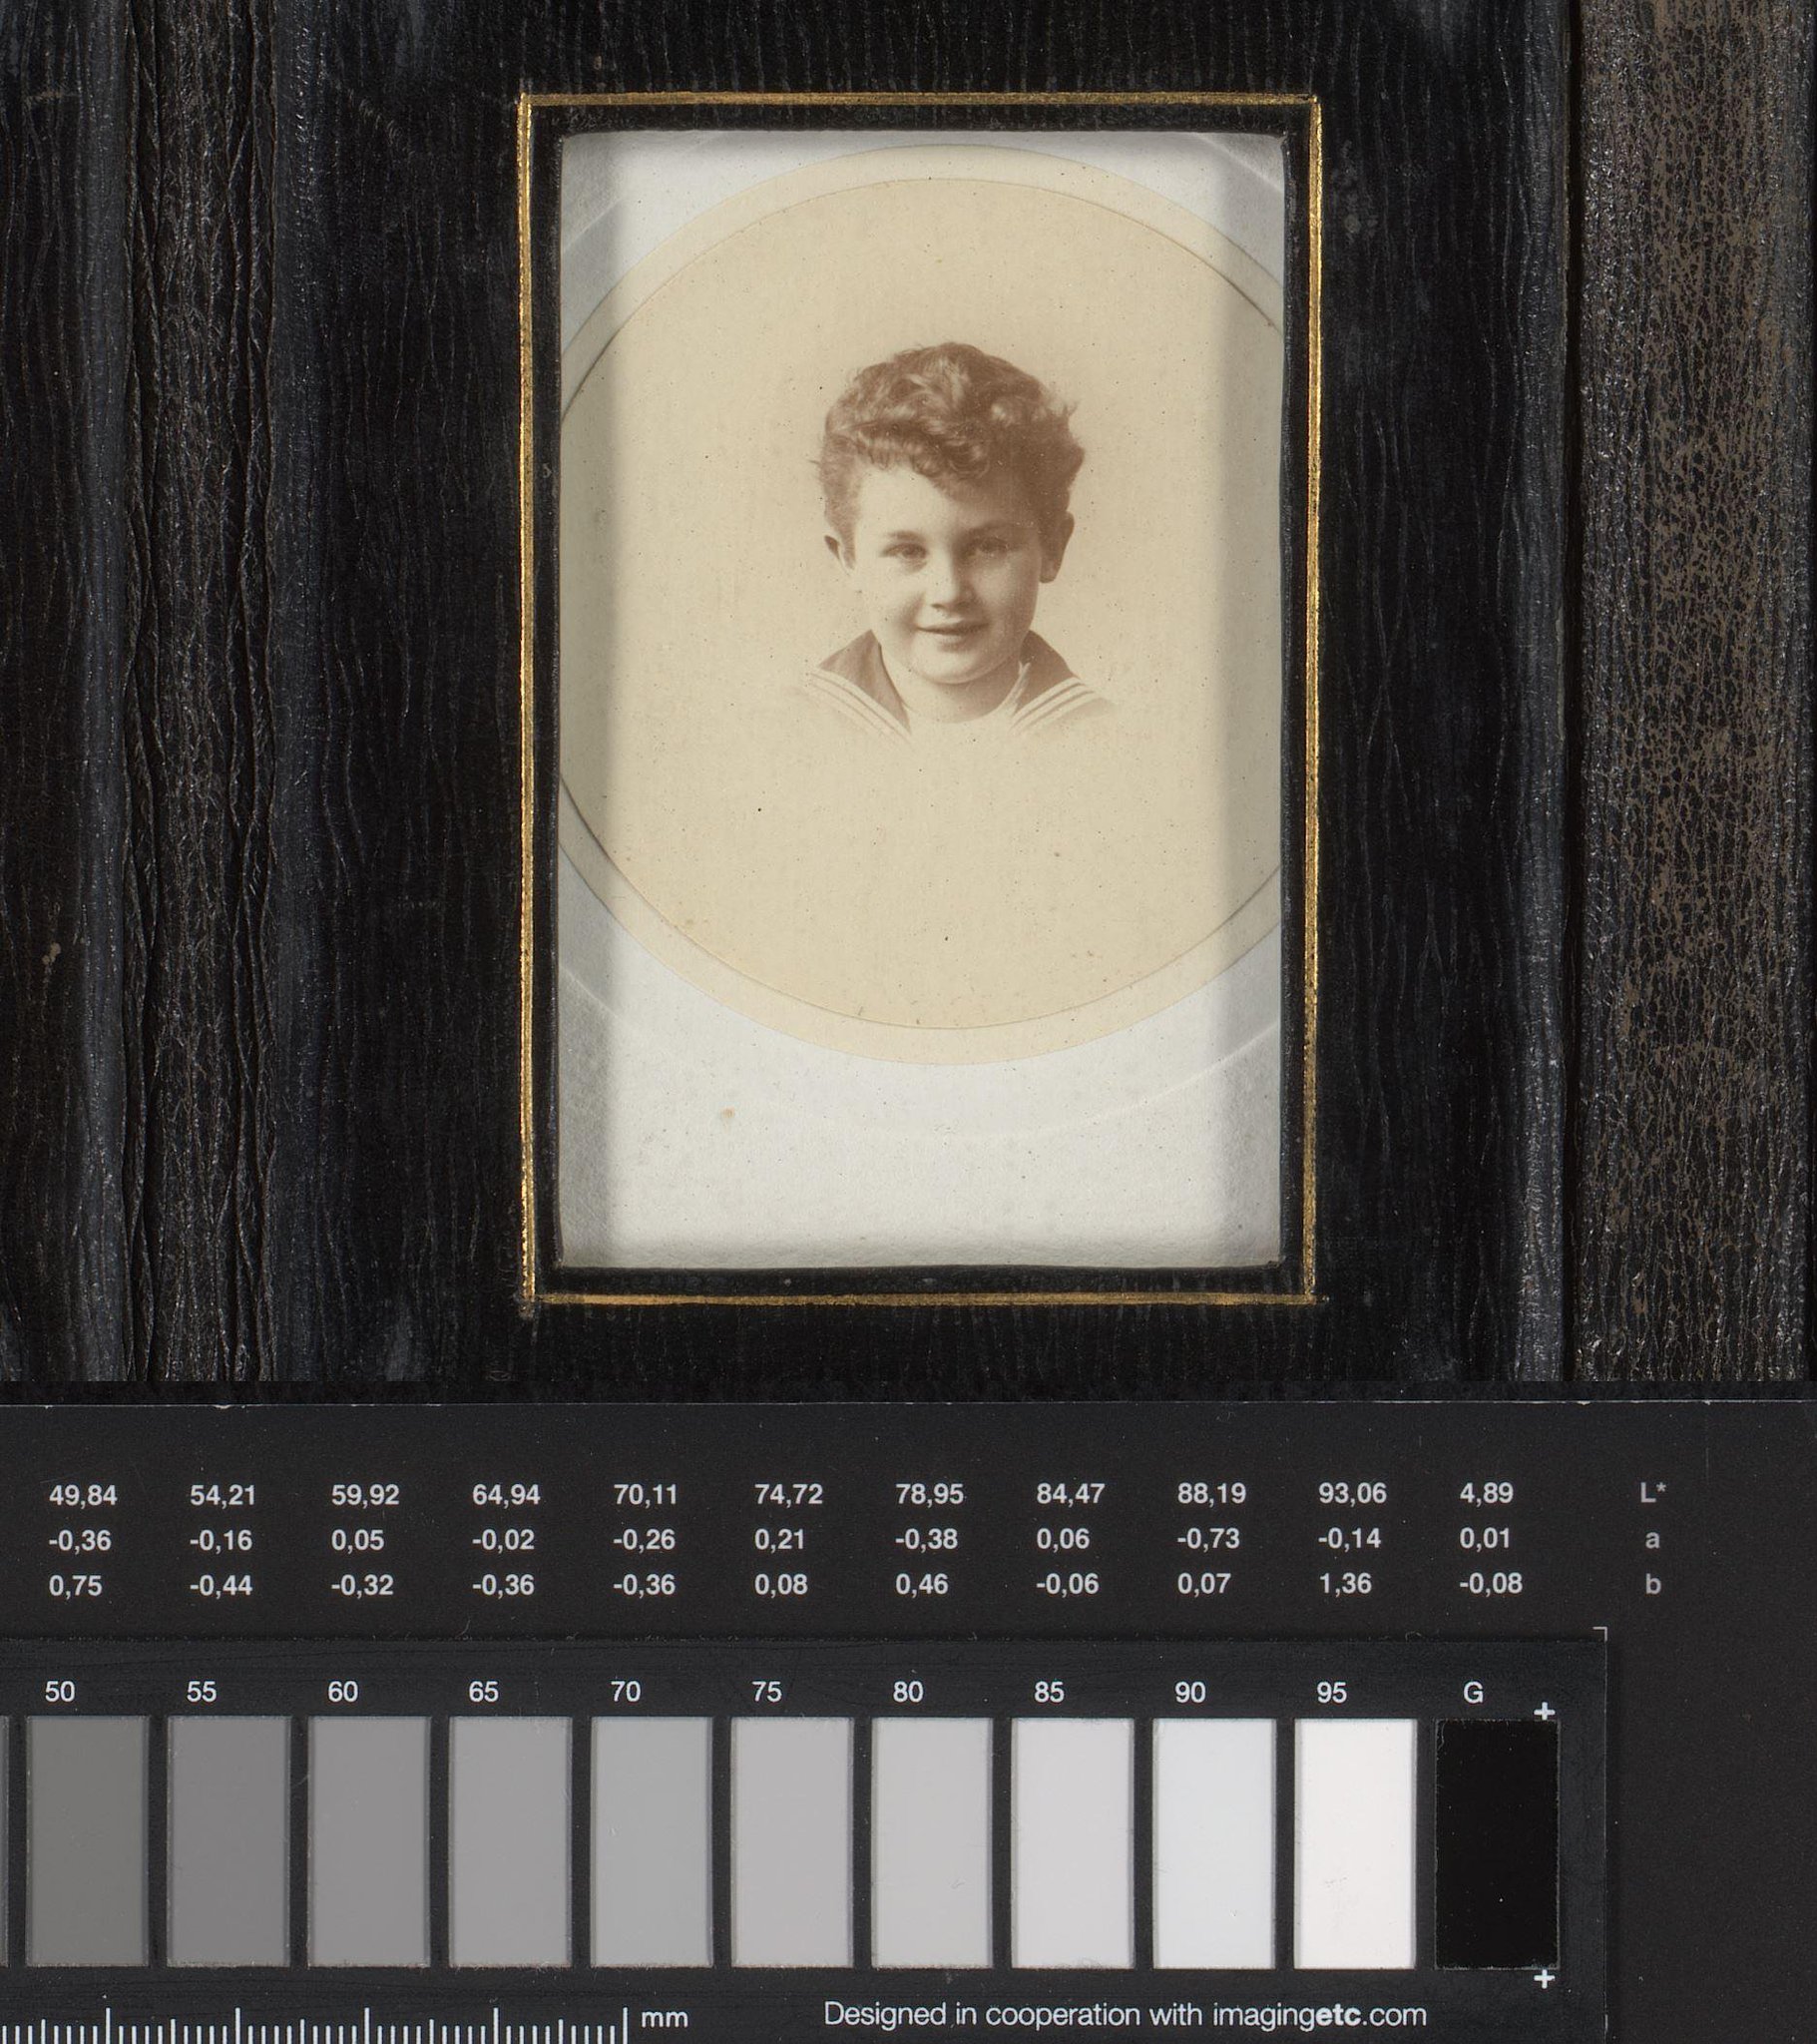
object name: photograph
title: Portret van Daniël François (Daan) Lunsingh Scheurleer als jongen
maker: else weissenborn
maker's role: fotograaf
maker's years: 1877-1950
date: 1910-1913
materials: cardboard, photographic support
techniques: gelatin silver print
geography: netherlands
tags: the hague, daniël françois lunsingh scheurleer, boy (child between toddler and youth)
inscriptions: name: ‘Opdruk onder de foto: Else Weissenborn, La H’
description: Daniël François (Daan) Lunsingh Scheurleer was later tijd directeur van de Dienst Verspreide Rijkscollecties.